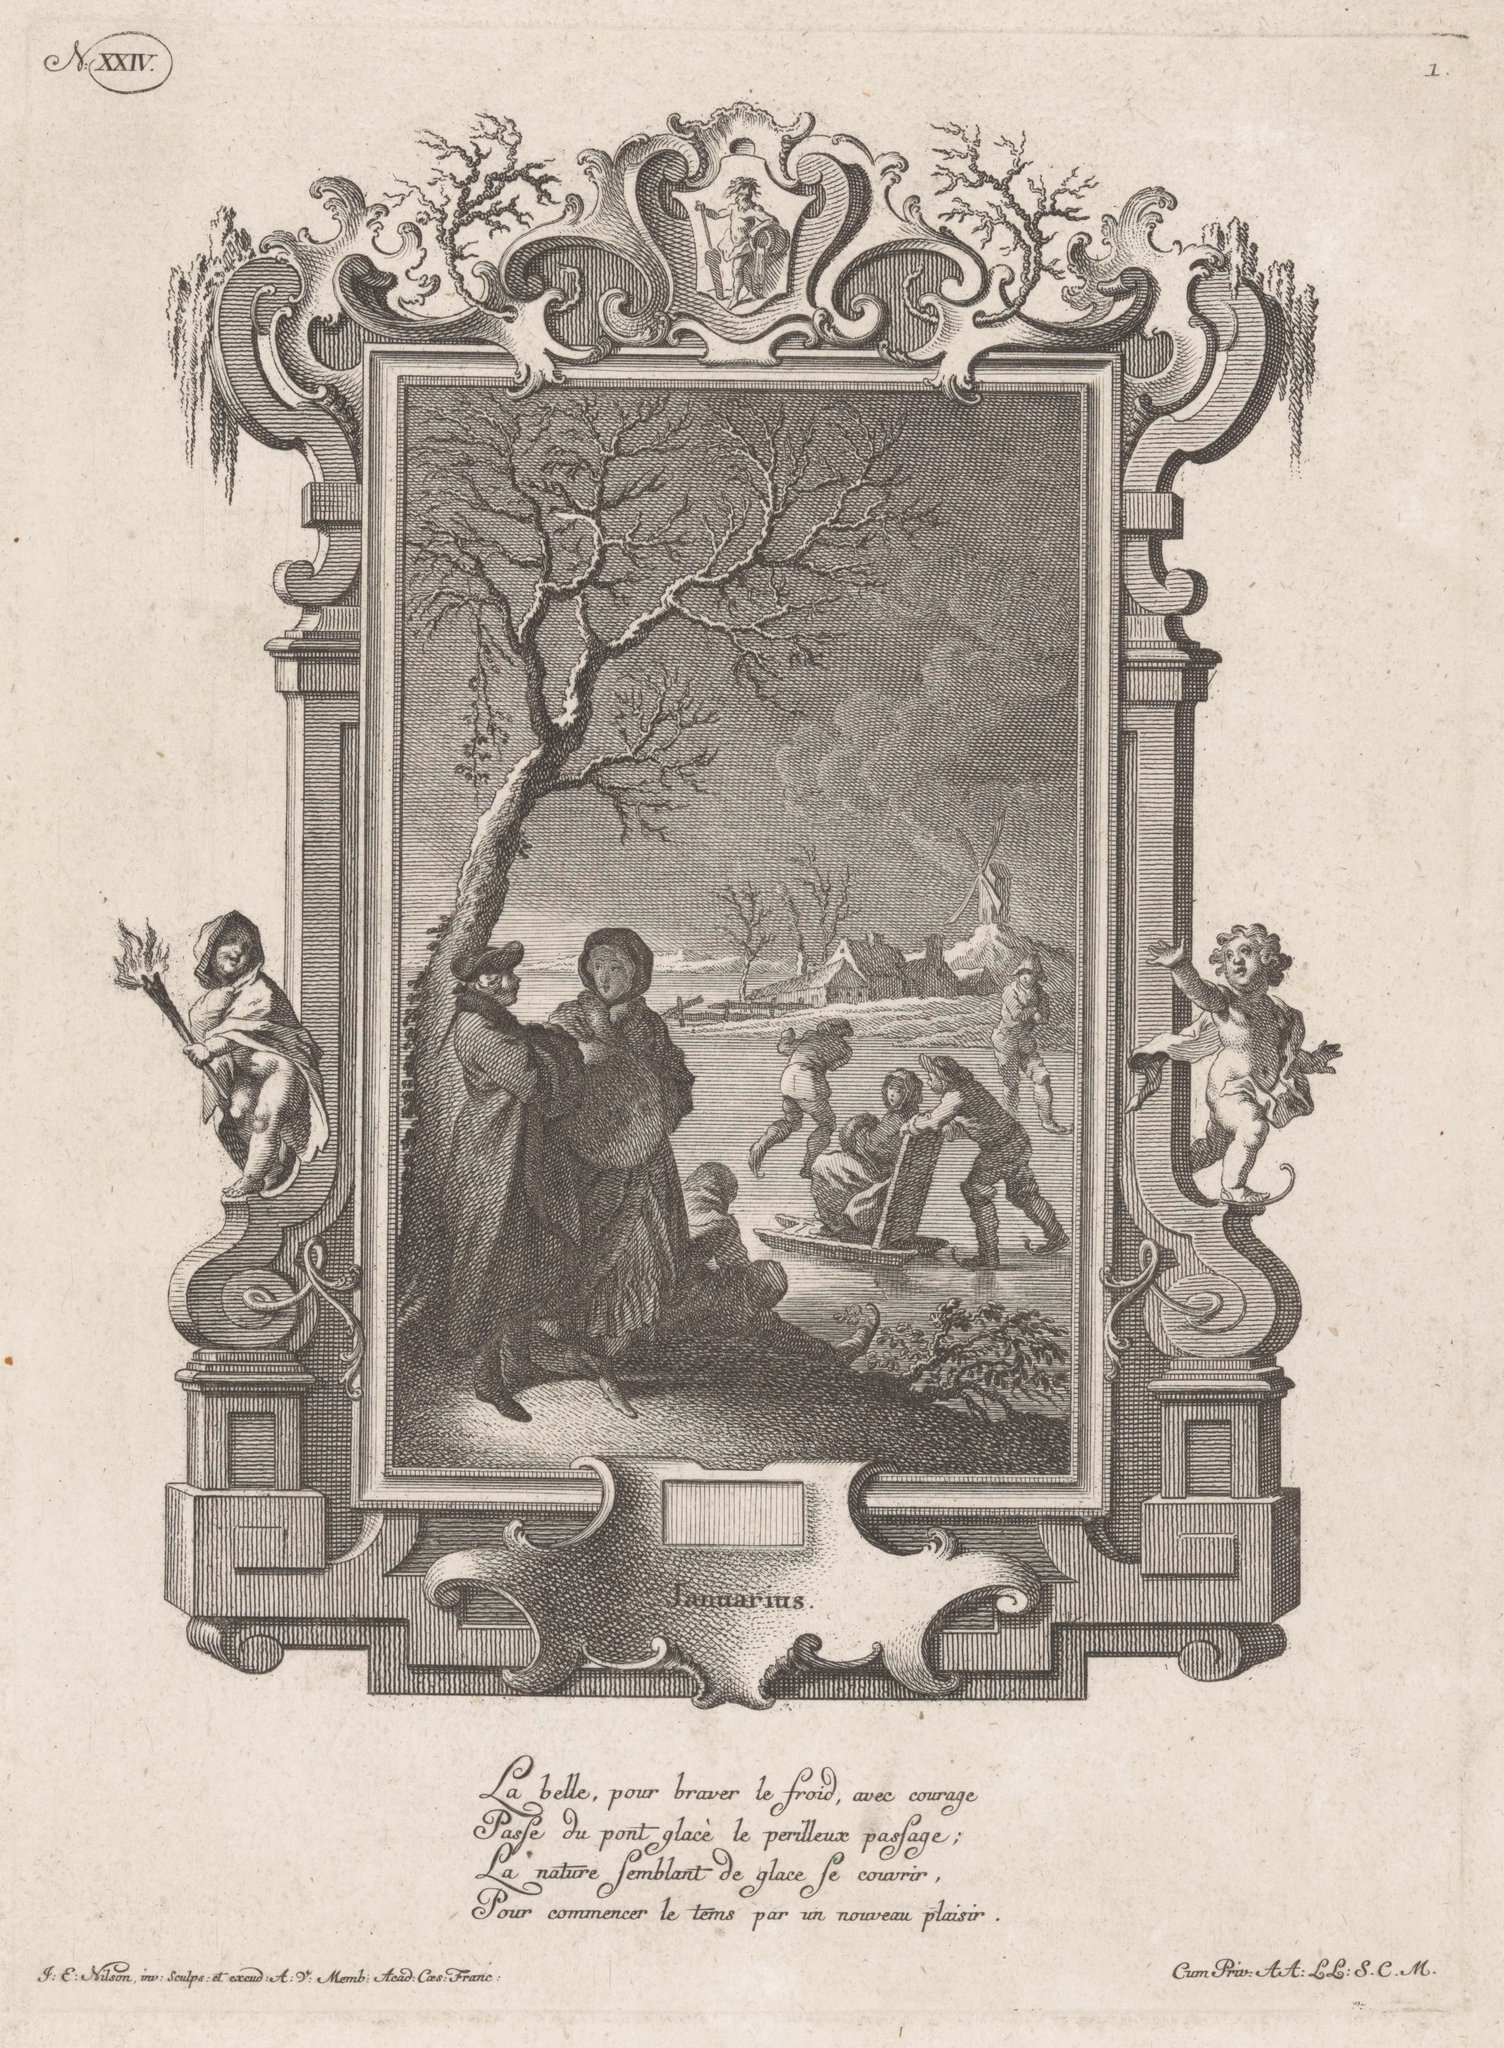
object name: print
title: Monument voor Paus Clemens XI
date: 1714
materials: paper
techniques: etching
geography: vatican city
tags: clemens xi, temperance, 'temperantia'; 'temperanza' (ripa) ~ one of the four cardinal virtues, justice, 'justitia'; 'giustitia divina' (ripa) ~ one of the four cardinal virtues, monument, statue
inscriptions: collector's mark: Lugt 2228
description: Monument voor Paus Clemens XI met zijn wapenschild, geflankeerd door Rechtsvaardigheid (Justitia) en Voorzichtigheid (Temperantia). Boven twee putti die een tiara en twee sleutels dragen.